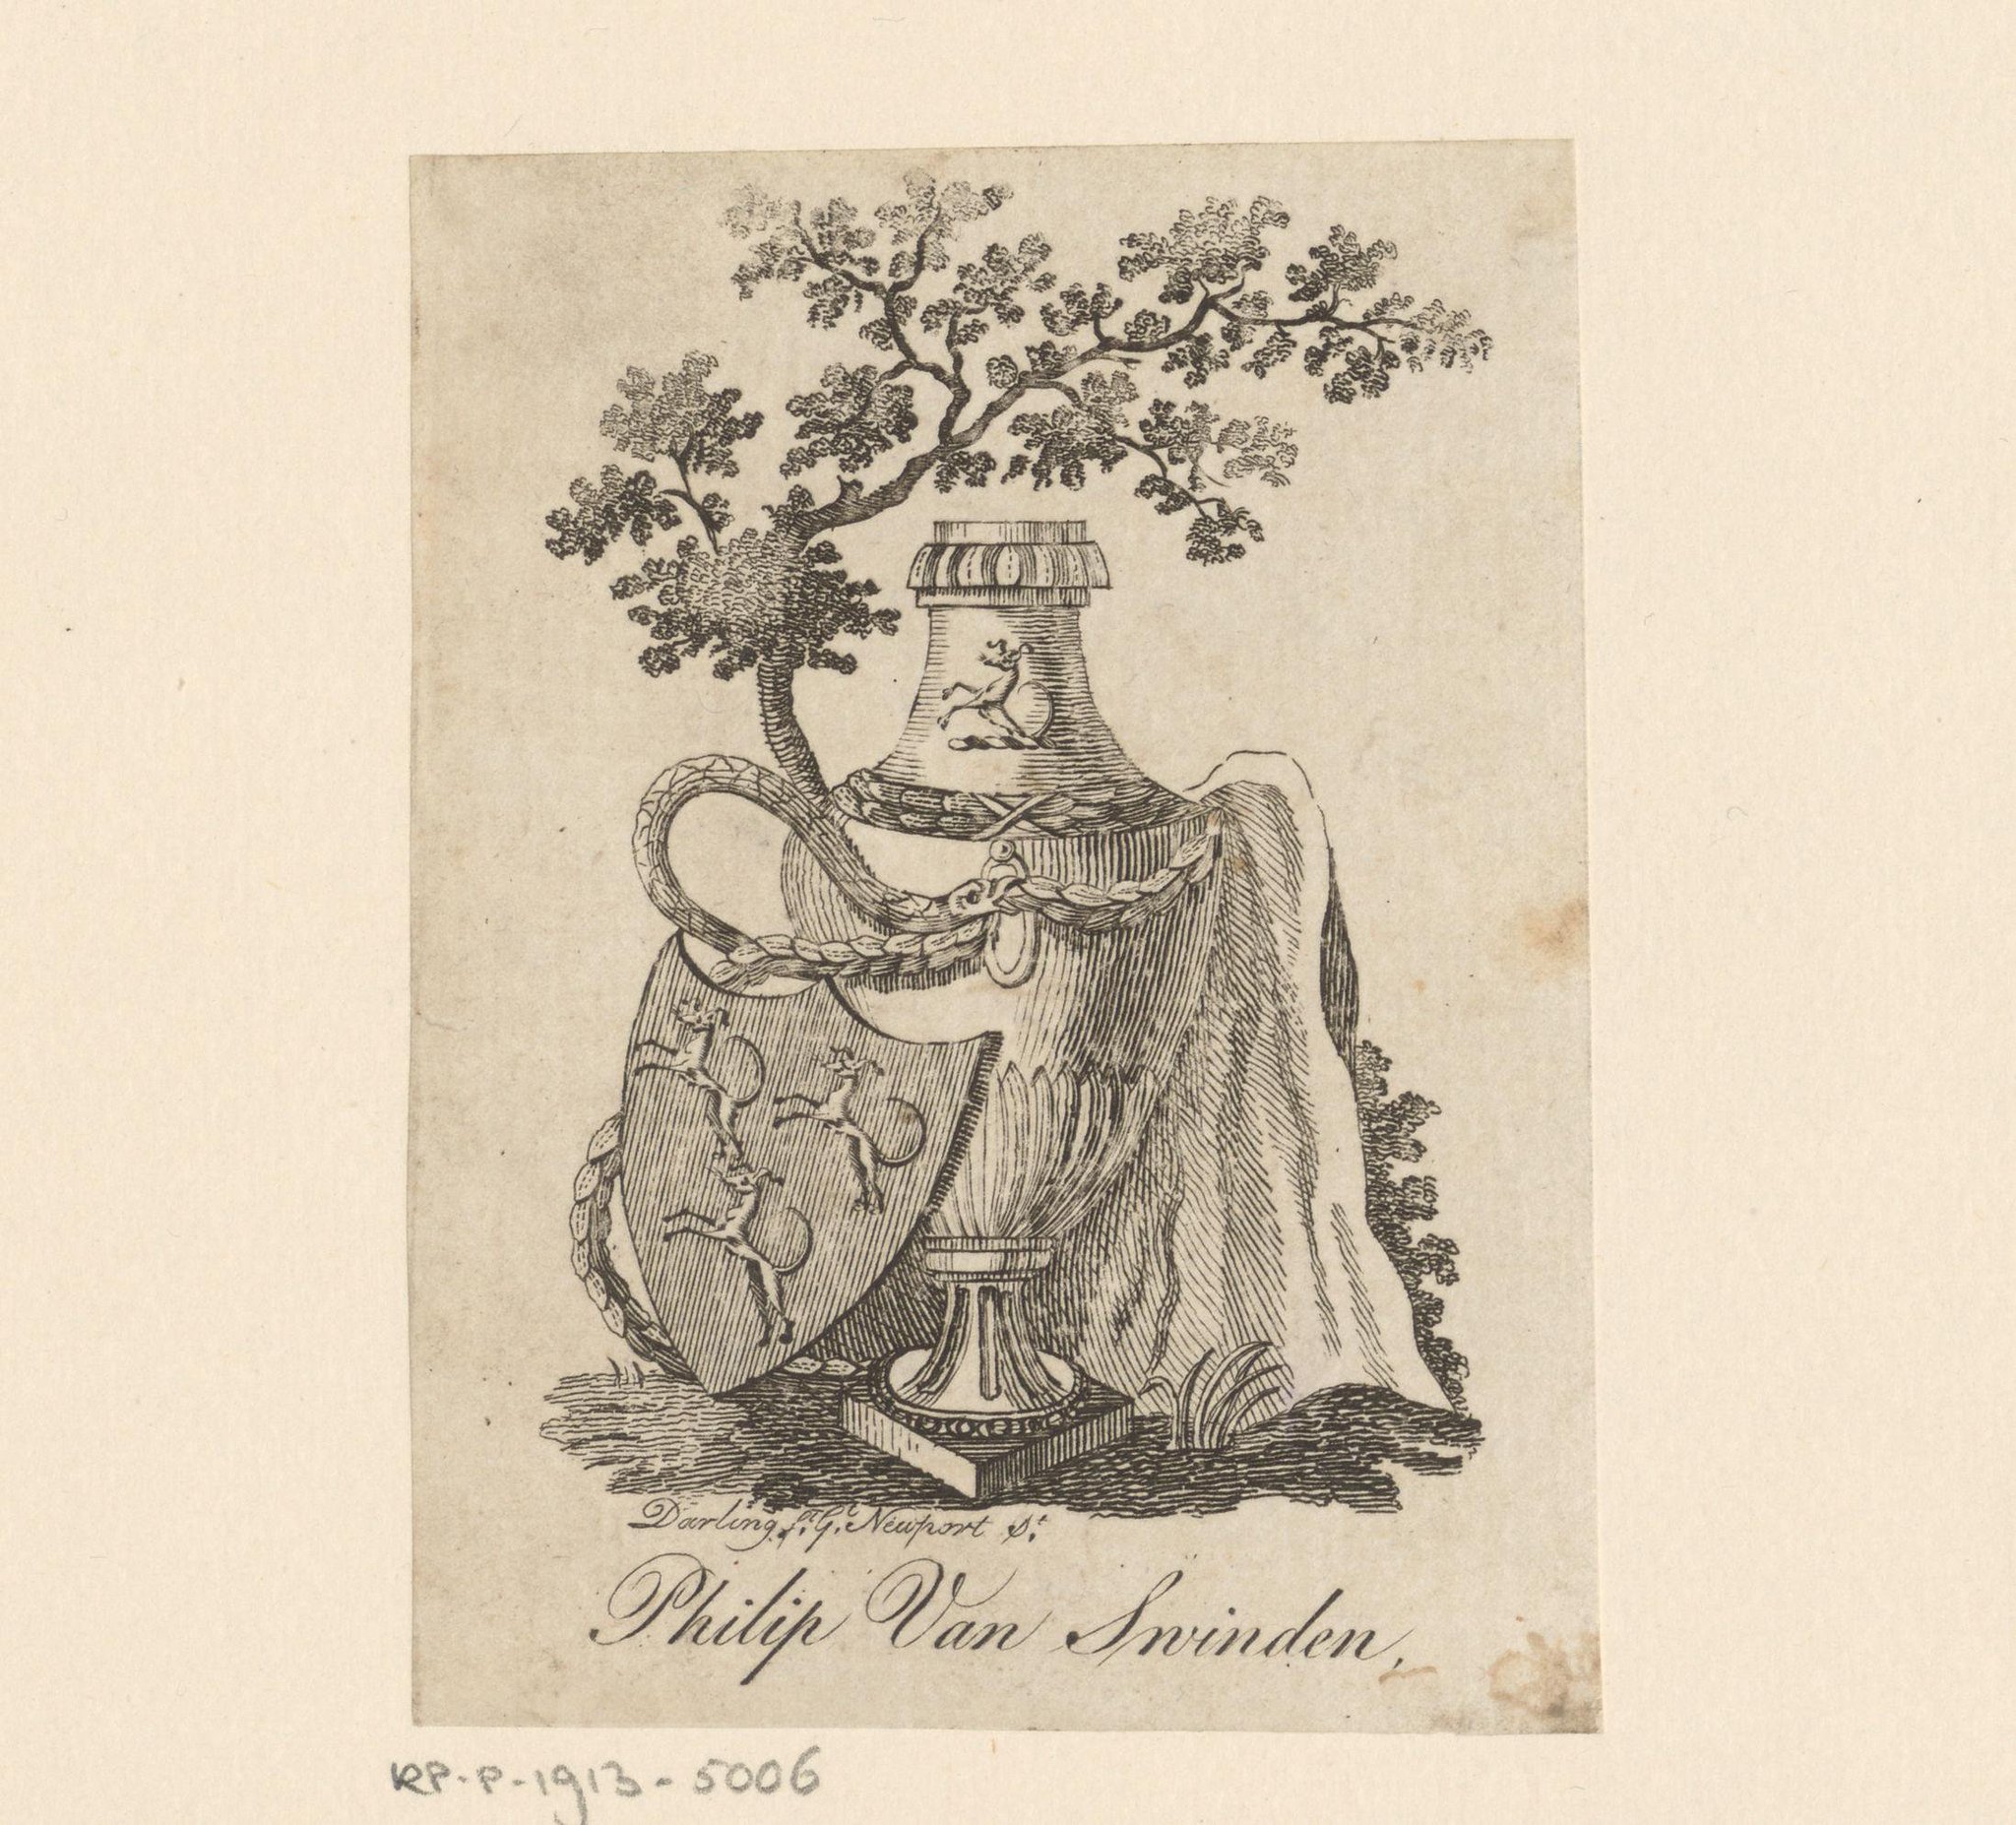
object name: bookplate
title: Ex libris van Philip van Swinden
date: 1750-1849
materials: paper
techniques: etching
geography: england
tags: trees, container of ceramics: jar, jug, pot, vase, armorial bearing, heraldry, dog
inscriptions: collector's mark: Lugt 2760, collector's mark: Lugt 2233